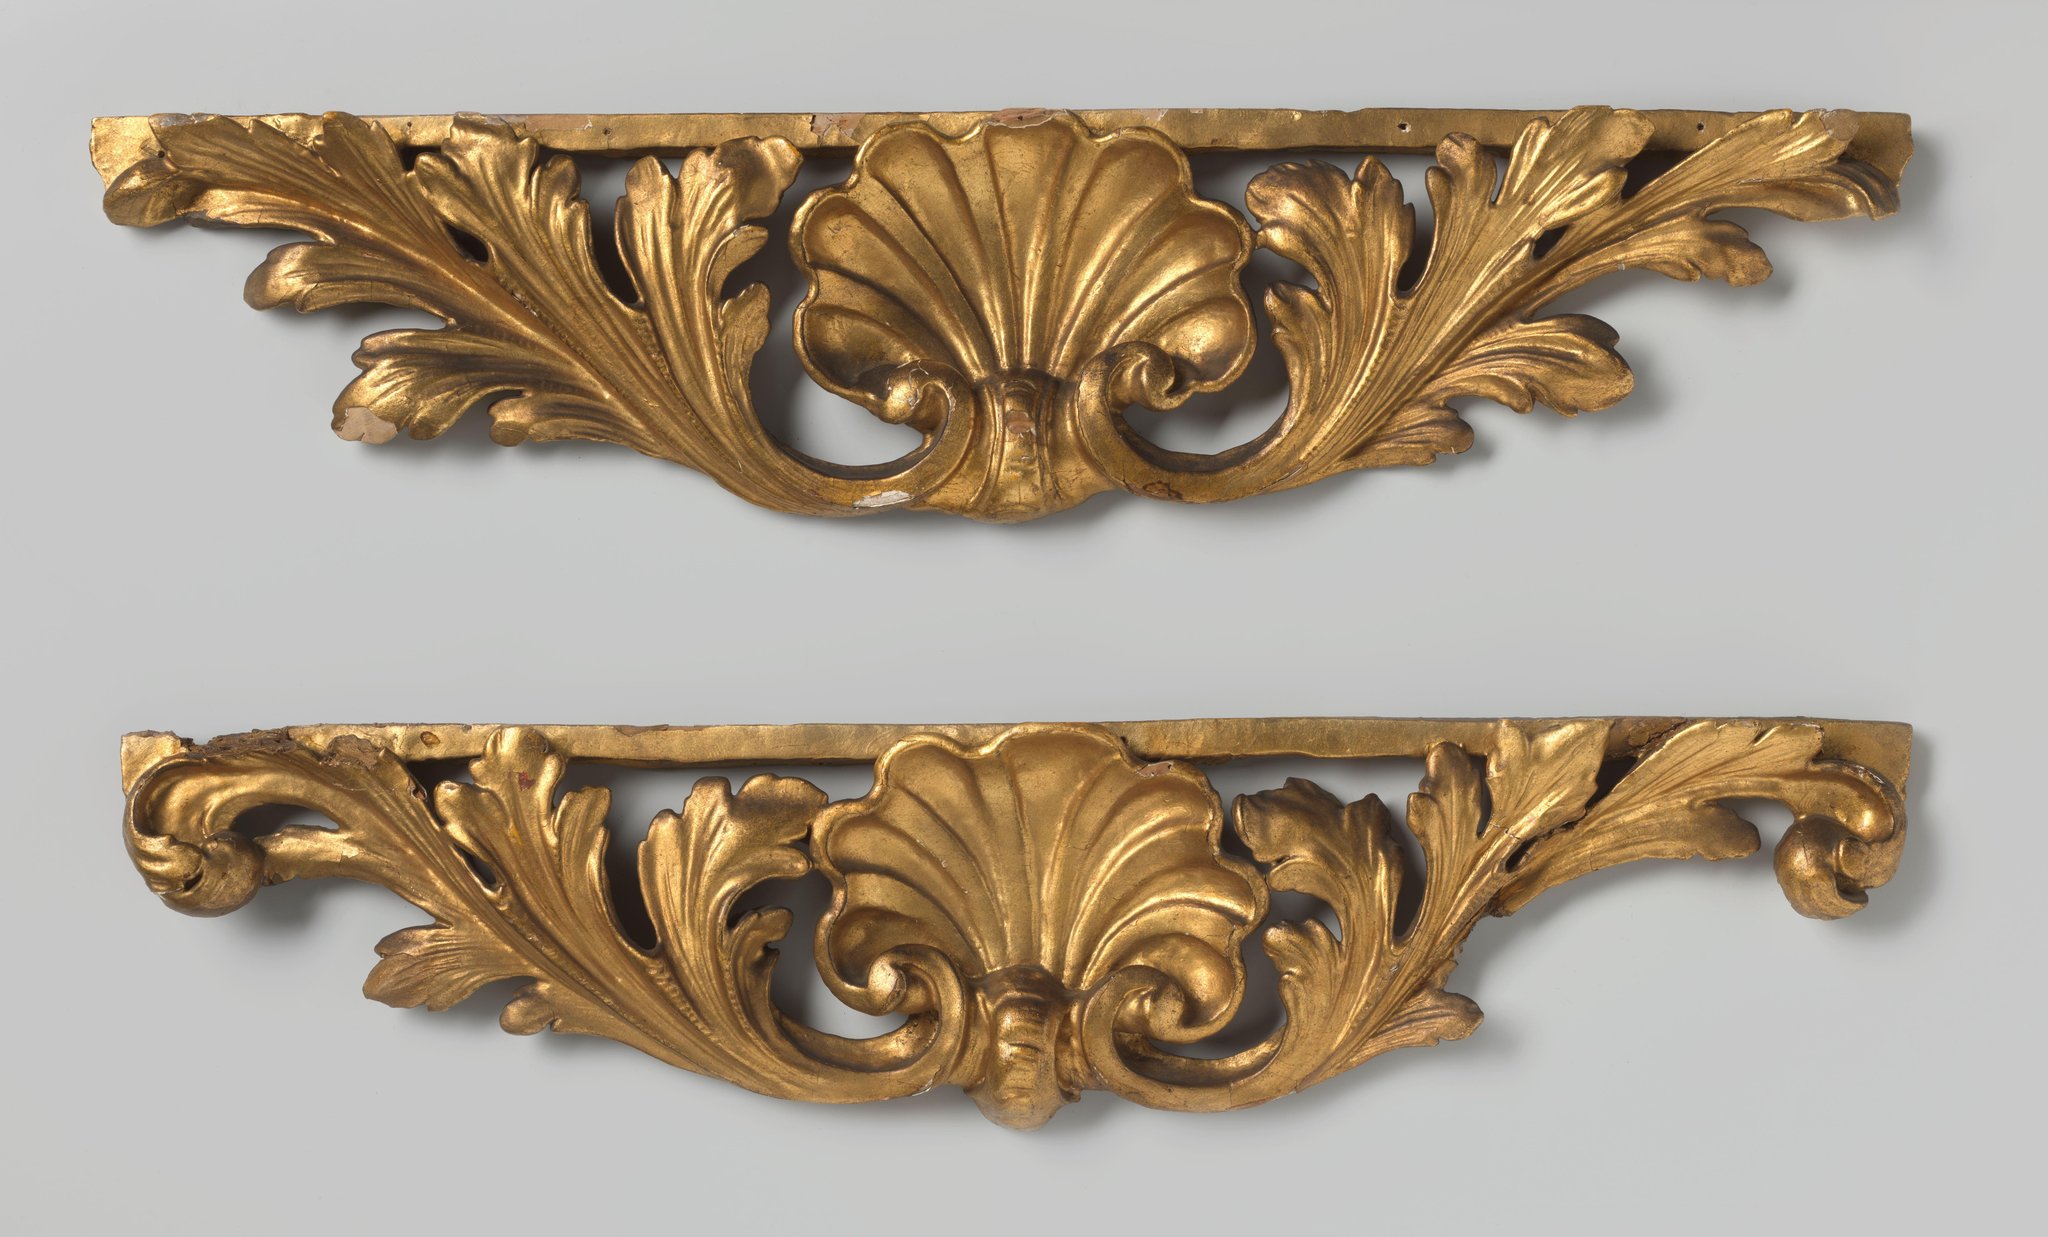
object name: table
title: Twee regels van gebeeldhouwd en verguld lindehout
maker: Anonymous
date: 1689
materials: wood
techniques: gilding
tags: ram's head ~ ornament, ornament ~ festoon, garland, cupids: 'amores', 'amoretti', 'putti', flowers ~ ornament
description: Twee onderdelen horend bij tafel BK-1962-49.